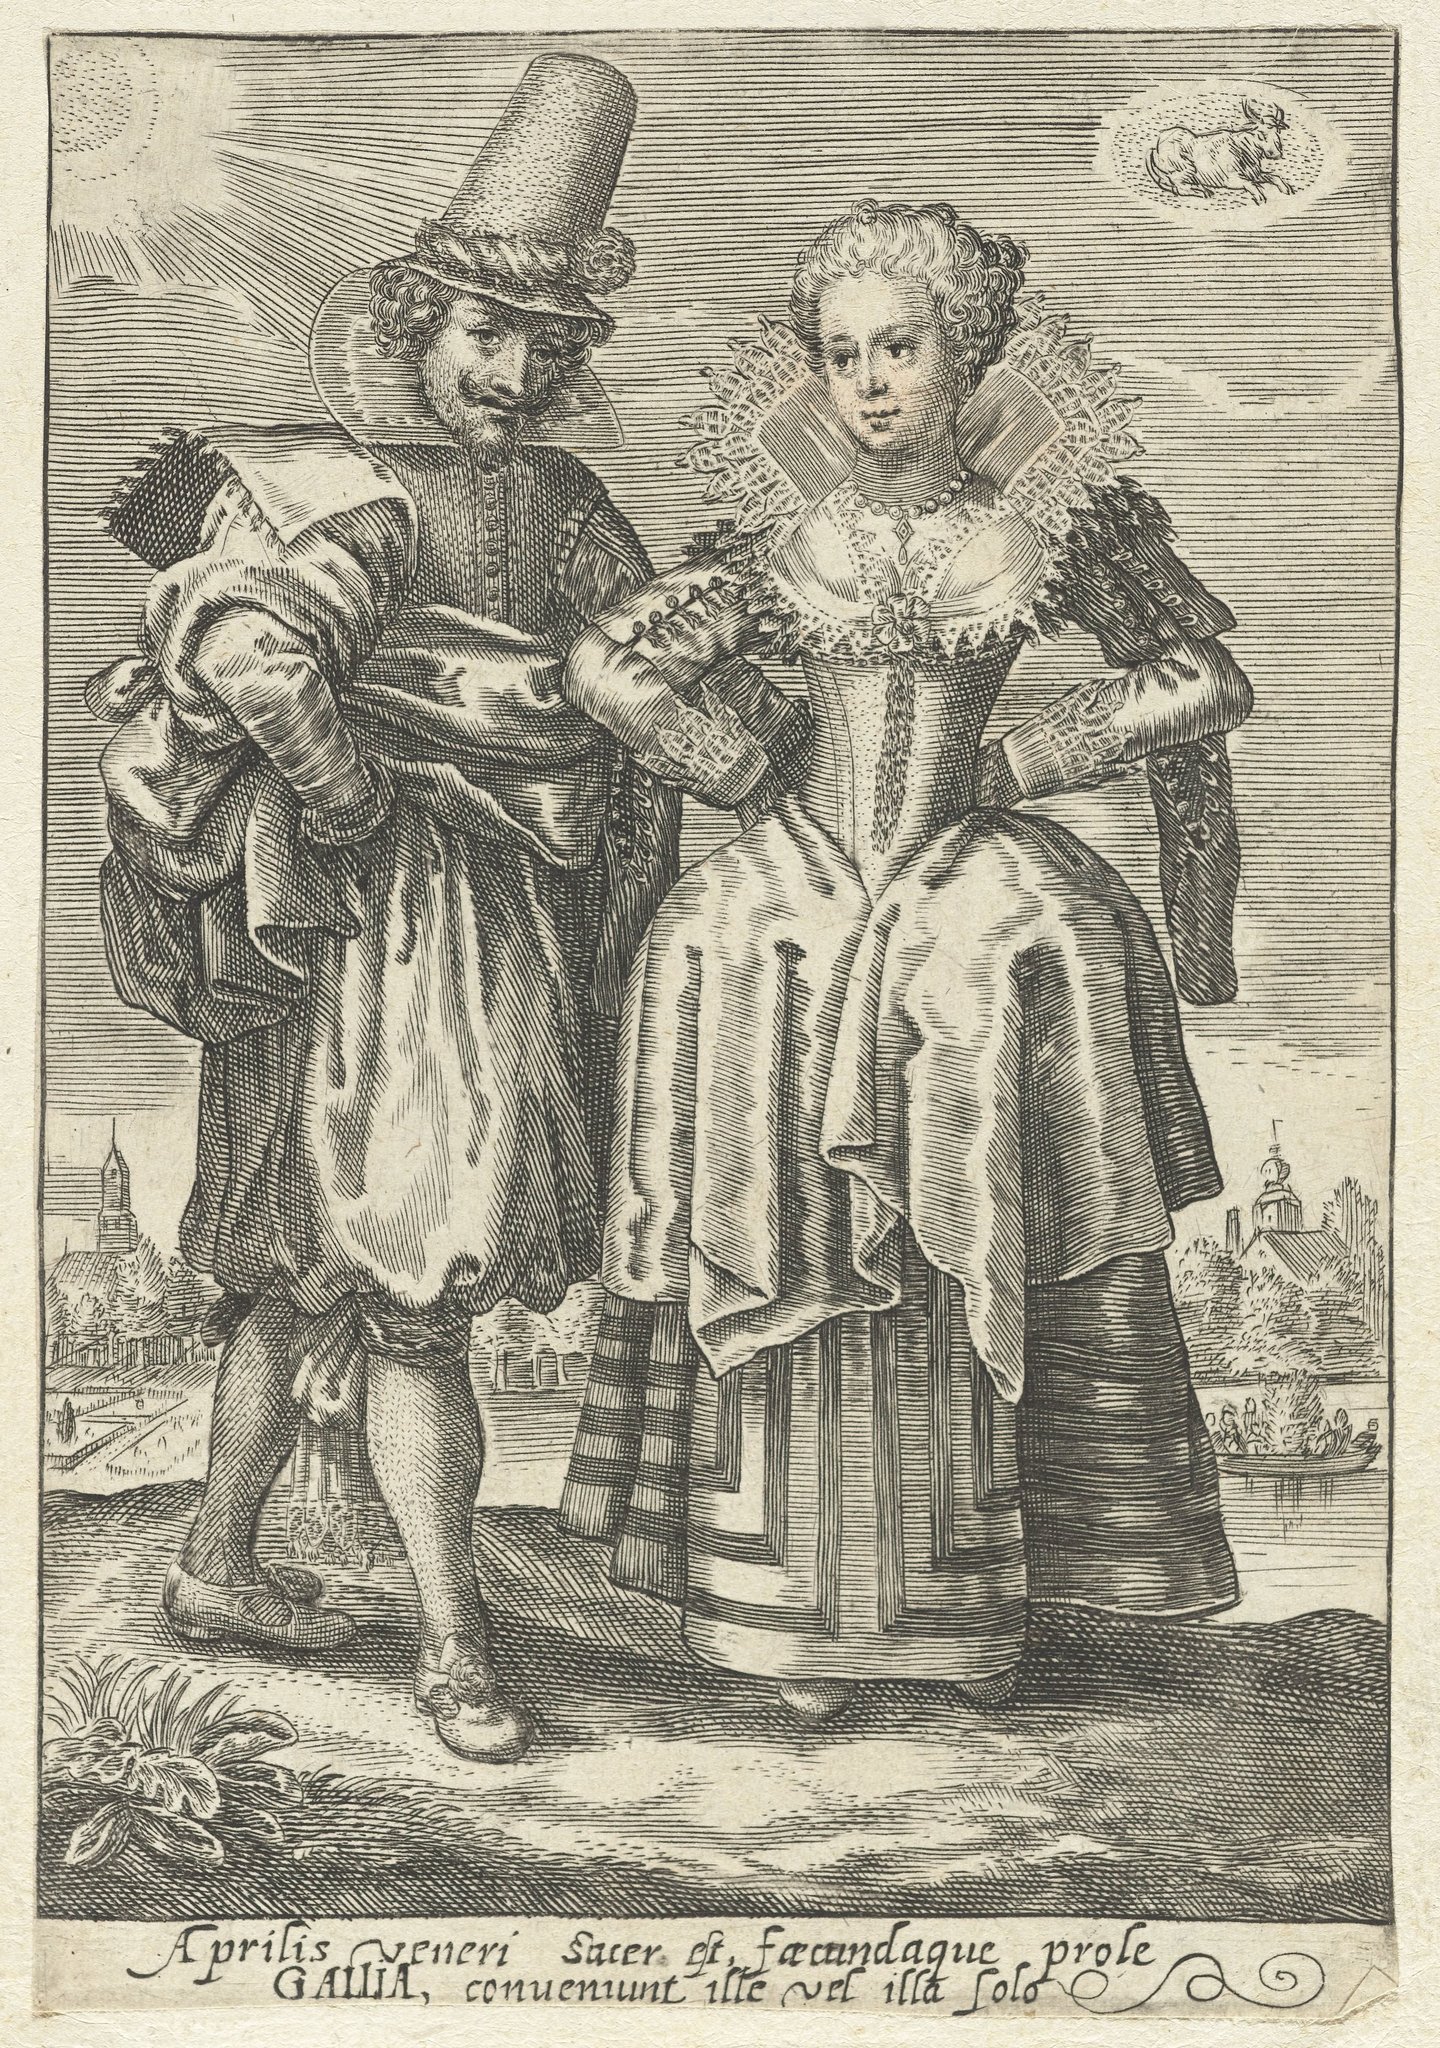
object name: costume print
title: De twaalf maanden met paren in kostuums uit verschillende landen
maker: crispijn van de passe (ii)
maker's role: draughtsman, print maker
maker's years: 1594-1670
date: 1620-1625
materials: paper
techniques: engraving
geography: northern netherlands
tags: taurus (zodiacal sign of april), sleeves, coat (+ men's clothes), skirt (underskirt) (+ women's clothes), head-gear: hat (+ men's clothes), neck-gear: collar (+ women's clothes), skirt (+ women's clothes), sleeves: cuffs (+ women's clothes), dress, gown (+ women's clothes), europeans (with name), shoes, sandals (+ men's clothes), neck-gear: collar (+ men's clothes), trousers, breeches, etc. (breeches) (+ men's clothes), clothing for the upper part of the body (doublet) (+ men's clothes), sleeves (+ women's clothes), clothing for the upper part of the body (with name) (+ women's clothes), april ~ other concepts, france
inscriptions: inscription: ‘110’, caption: ‘Aprilis veneri sacer est, foecundaque prole / GALLIA , conueniunt ille, vel illa solo.’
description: Man en vrouw uit Frankrijk, gekleed volgens de mode van ca. 1620. Boven hen het teken van Stier. Op de achtergrond gezicht op een stad aan een rivier. In de marge een tweeregelig onderschrift in het Latijn. Prent uit een serie met de twaalf maanden weergegeven door tekens van de dierenriem en paren die kleding uit verschillende landen dragen.